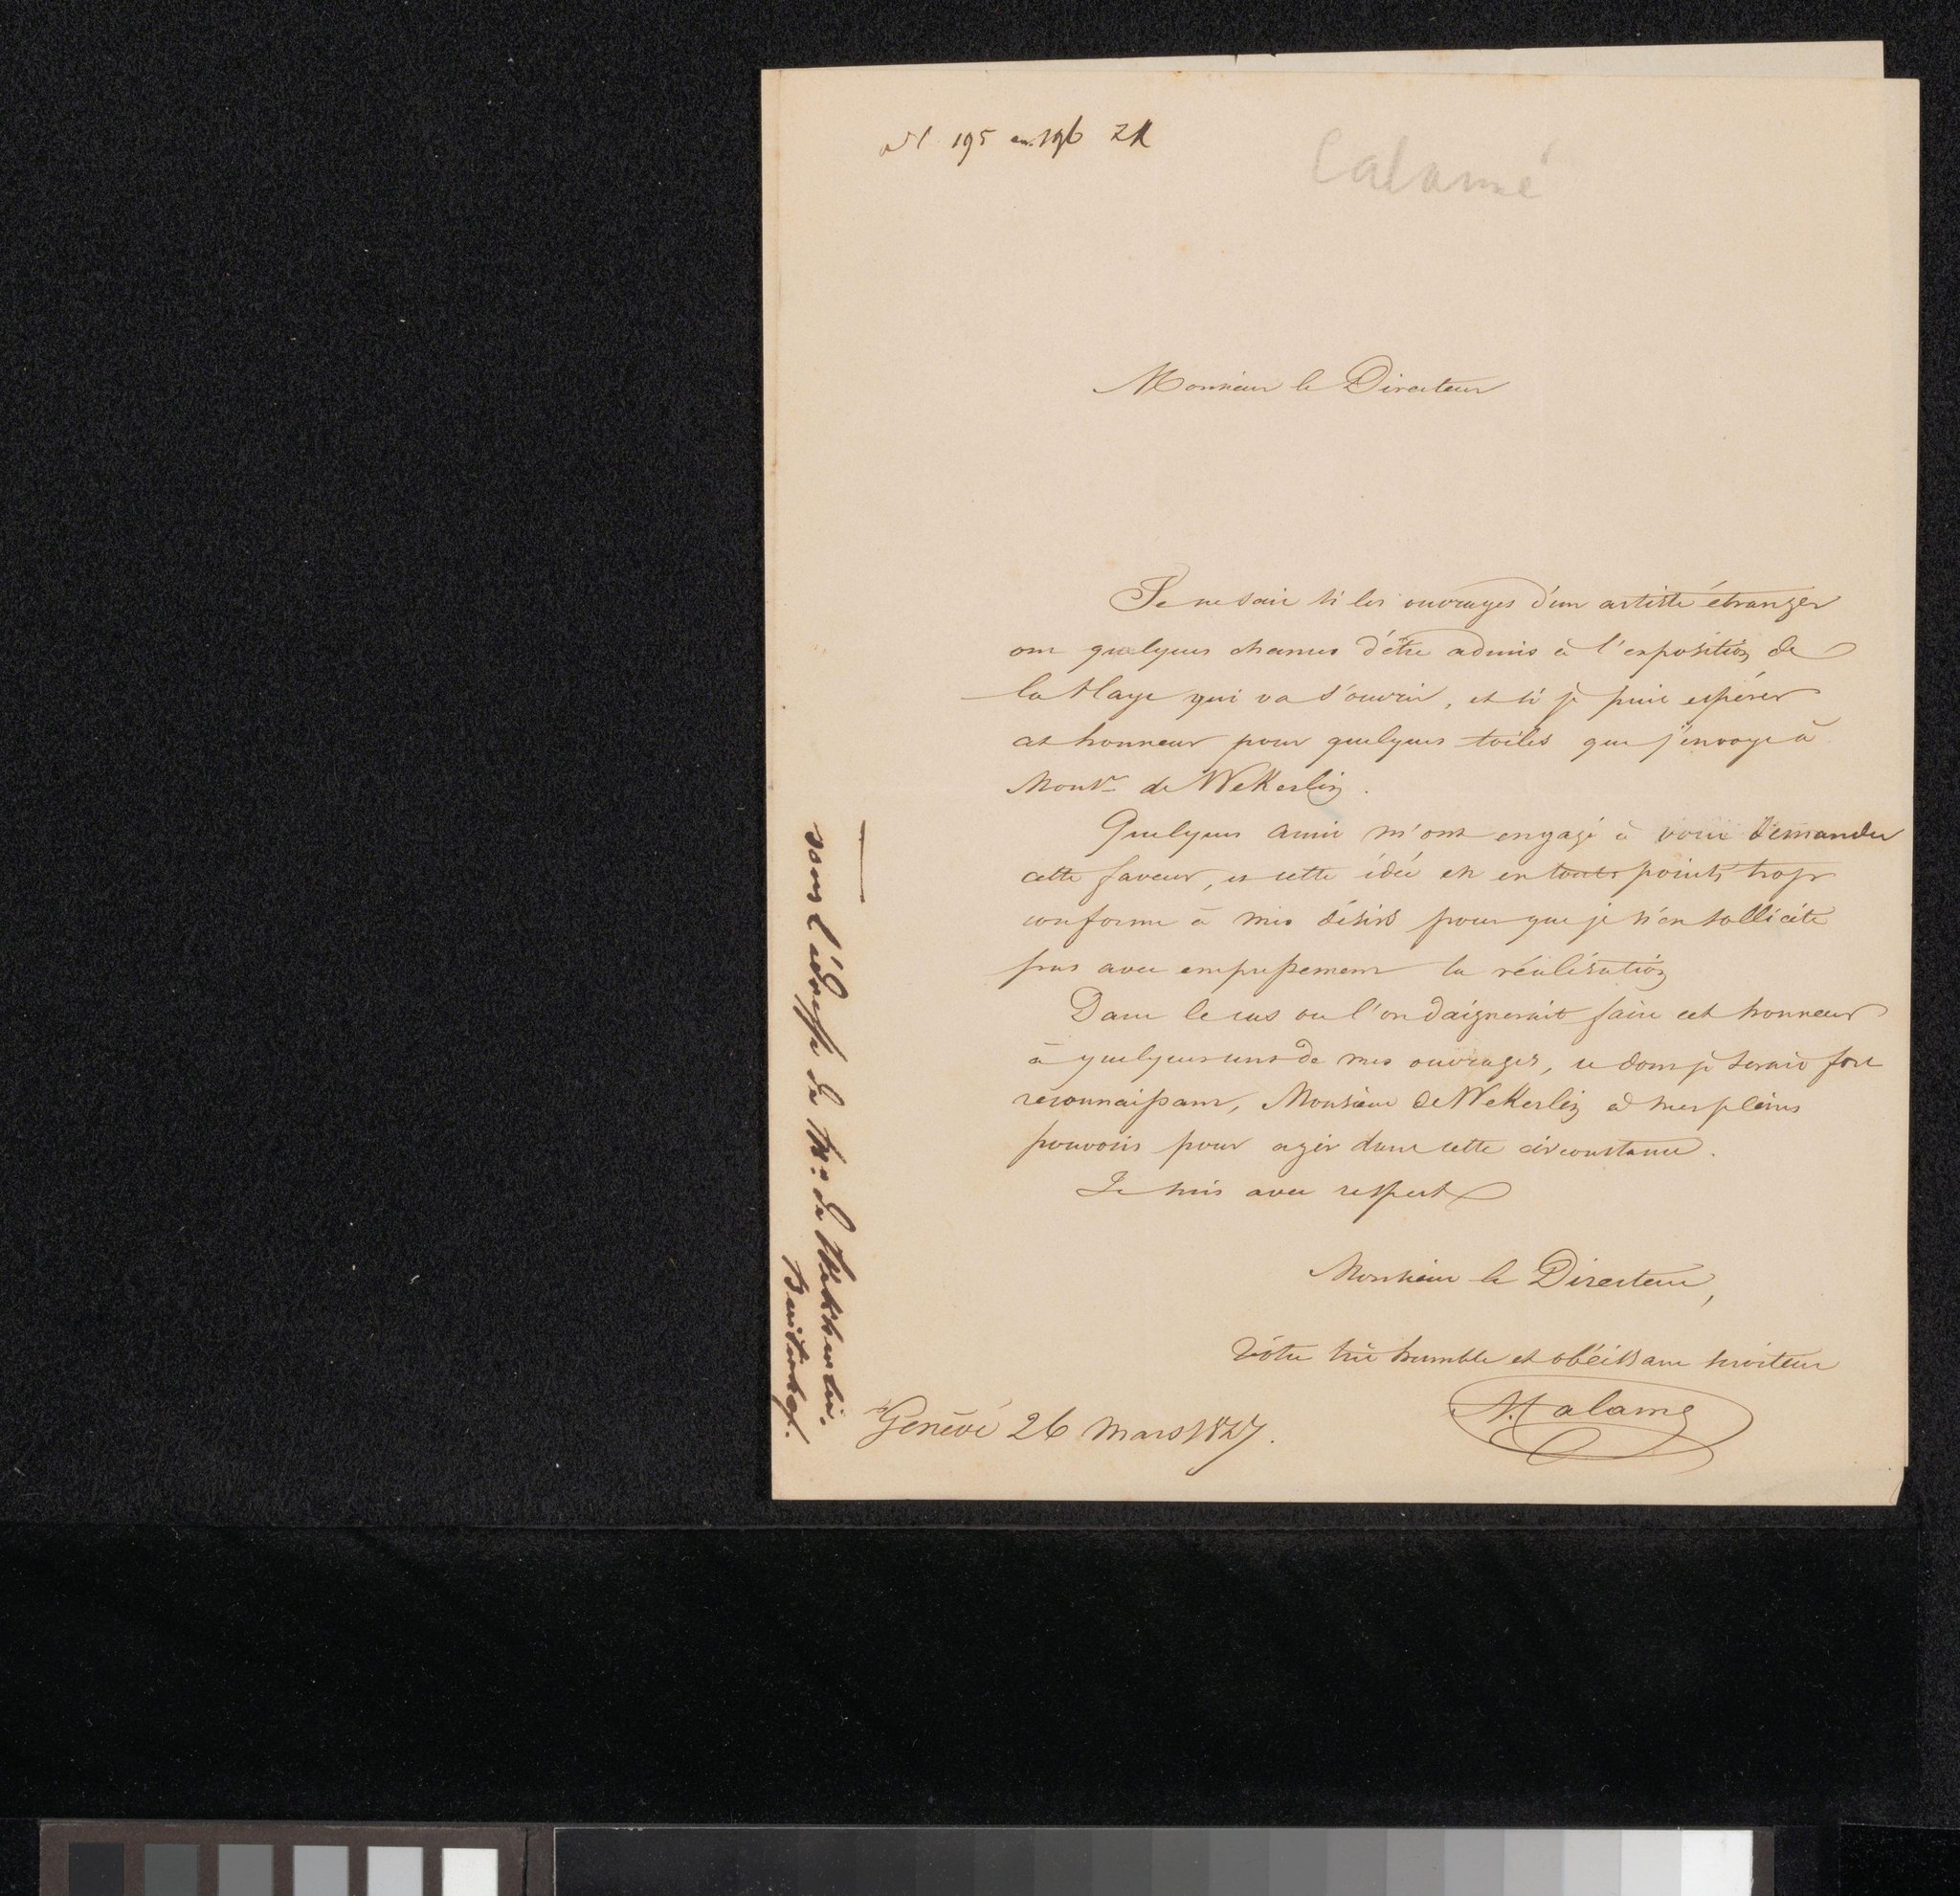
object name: letter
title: Brief aan onbekend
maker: alexandre calame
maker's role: draughtsman, painter, print maker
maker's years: 1810-1864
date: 1847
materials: ink, paper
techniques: pen, writing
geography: geneva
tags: painting (including book-illumination, miniature-painting), exhibition ~ art, the hague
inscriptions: watermark, collector's mark: Lugt 2228